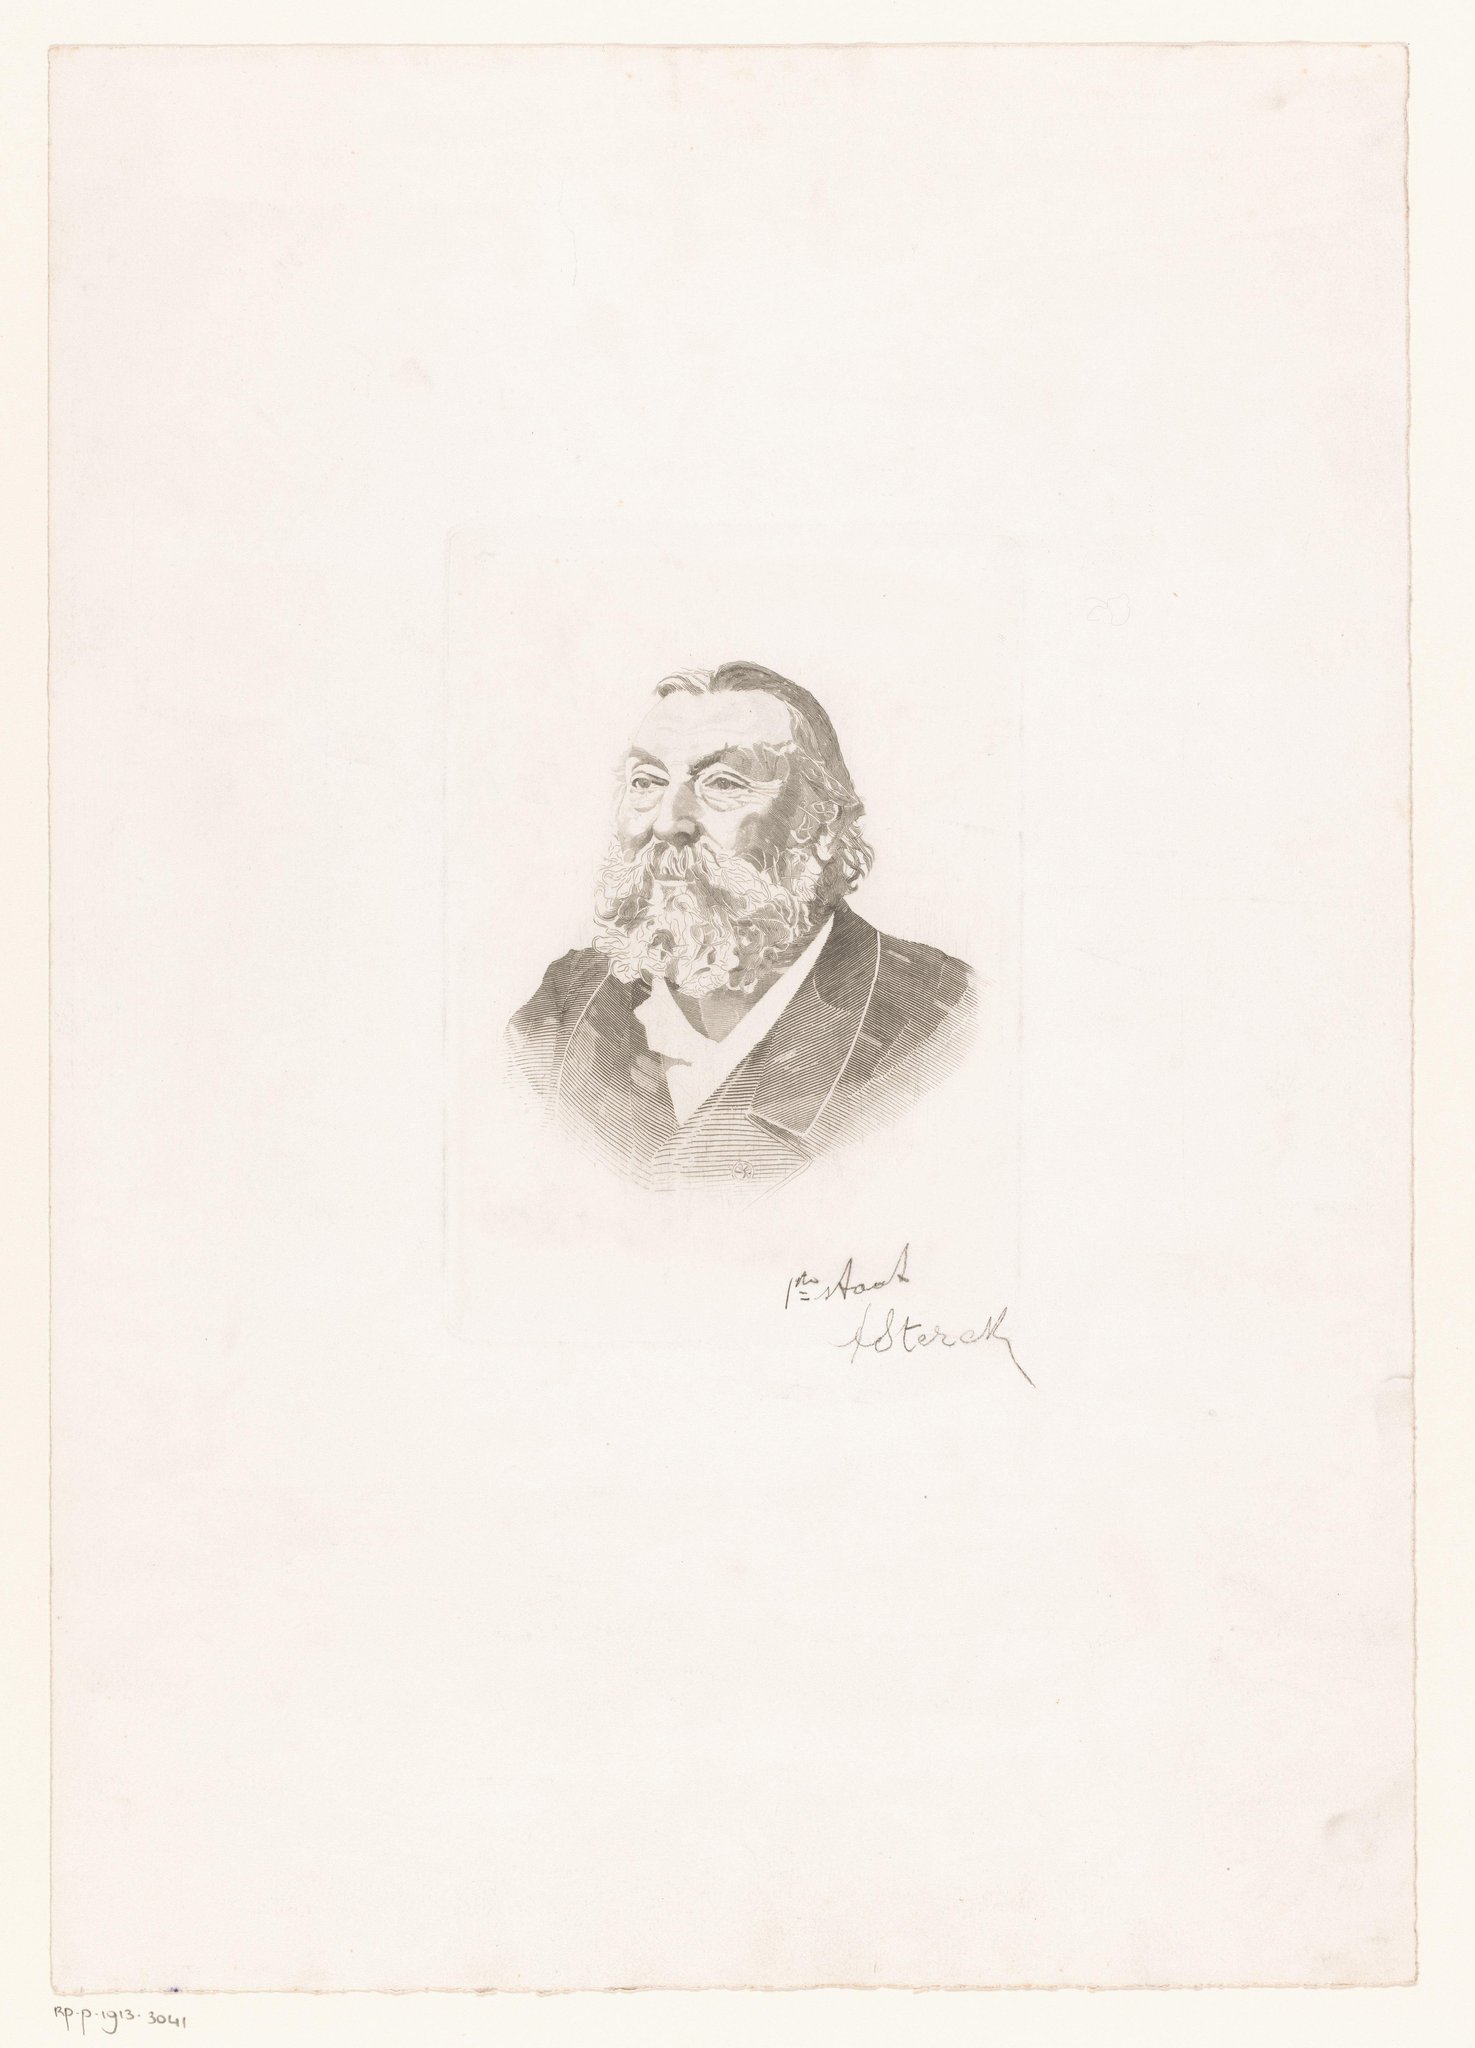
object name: print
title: Portret van Peter Benoît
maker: arthur sterck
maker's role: print maker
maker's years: 1868-1897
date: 1894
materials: paper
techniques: etching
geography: antwerp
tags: historical persons, portrait of composer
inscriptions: collector's mark: Lugt 2228, annotation: ‘1ste staat’